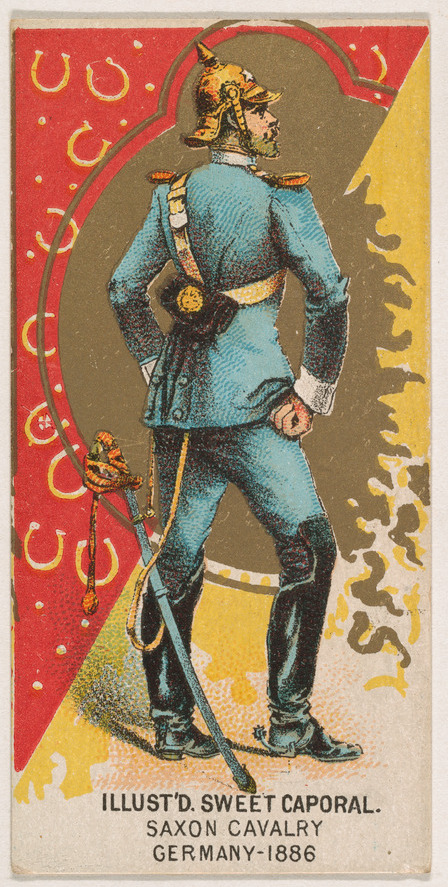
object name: print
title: Saxon Cavalry, Germany, 1886, from the Military Series (N224) issued by Kinney Tobacco Company to promote Sweet Caporal Cigarettes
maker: kinney brothers tobacco company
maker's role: publisher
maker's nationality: american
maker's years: 1869-2011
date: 1888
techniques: color lithograph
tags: soldiers,men,profiles